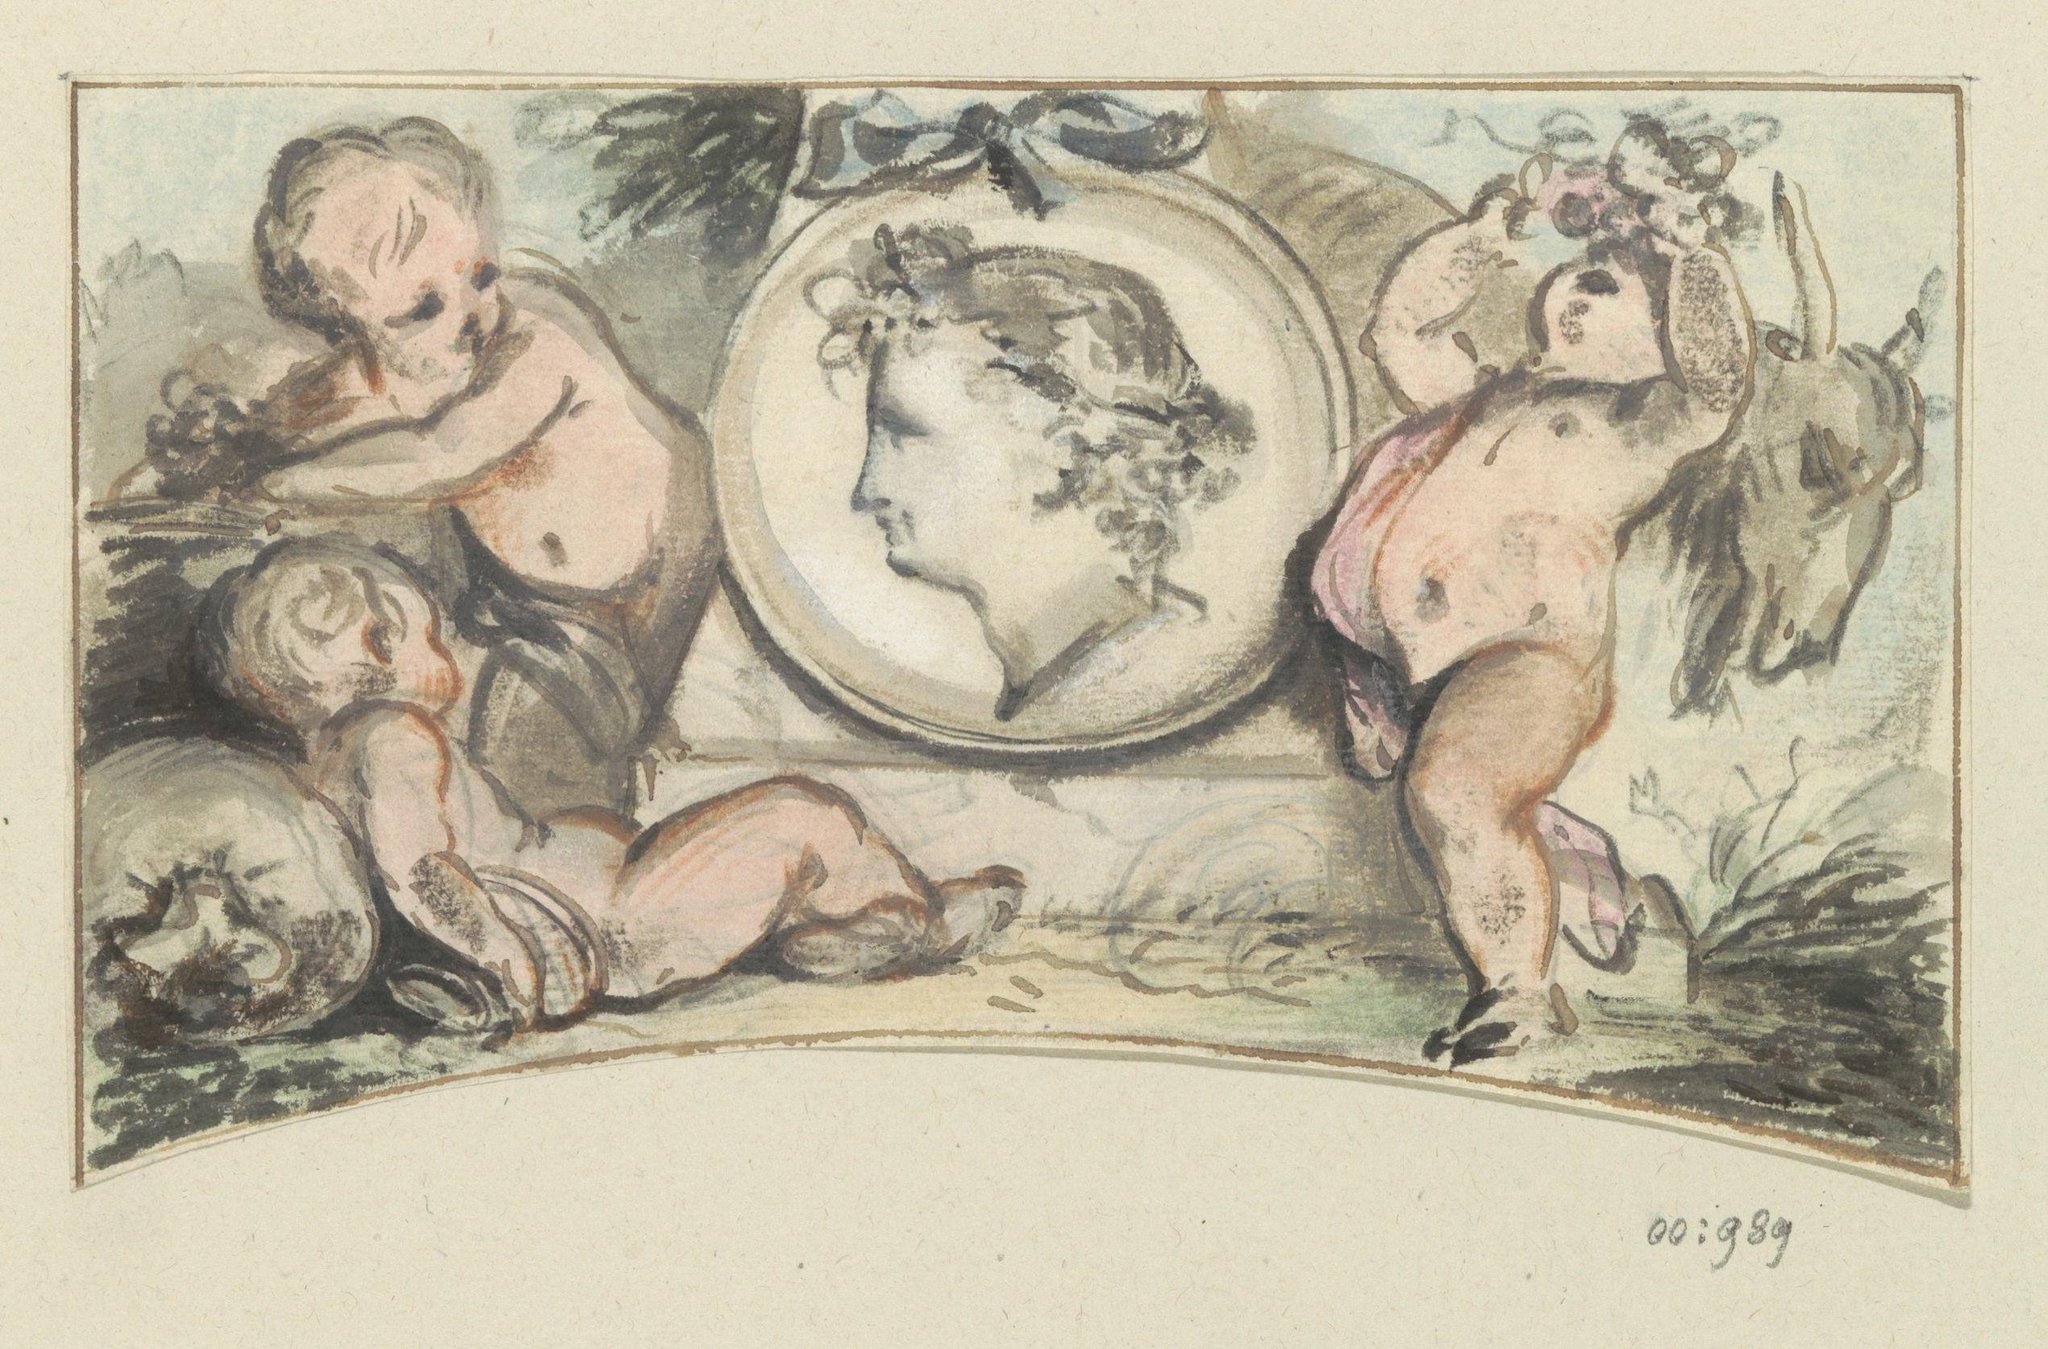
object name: album leaf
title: Medaillon met Bacchus omringd door drie putti en een geit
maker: jurriaan andriessen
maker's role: draughtsman, painter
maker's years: 1742-1819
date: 1760-1819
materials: chalk, paper, pencil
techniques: brush, pen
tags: (story of) bacchus (dionysus), liber, goat, cupids: 'amores', 'amoretti', 'putti'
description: Mogelijk een ontwerptekening voor een kamerdecoratie. Tekening maakt deel uit van een album.